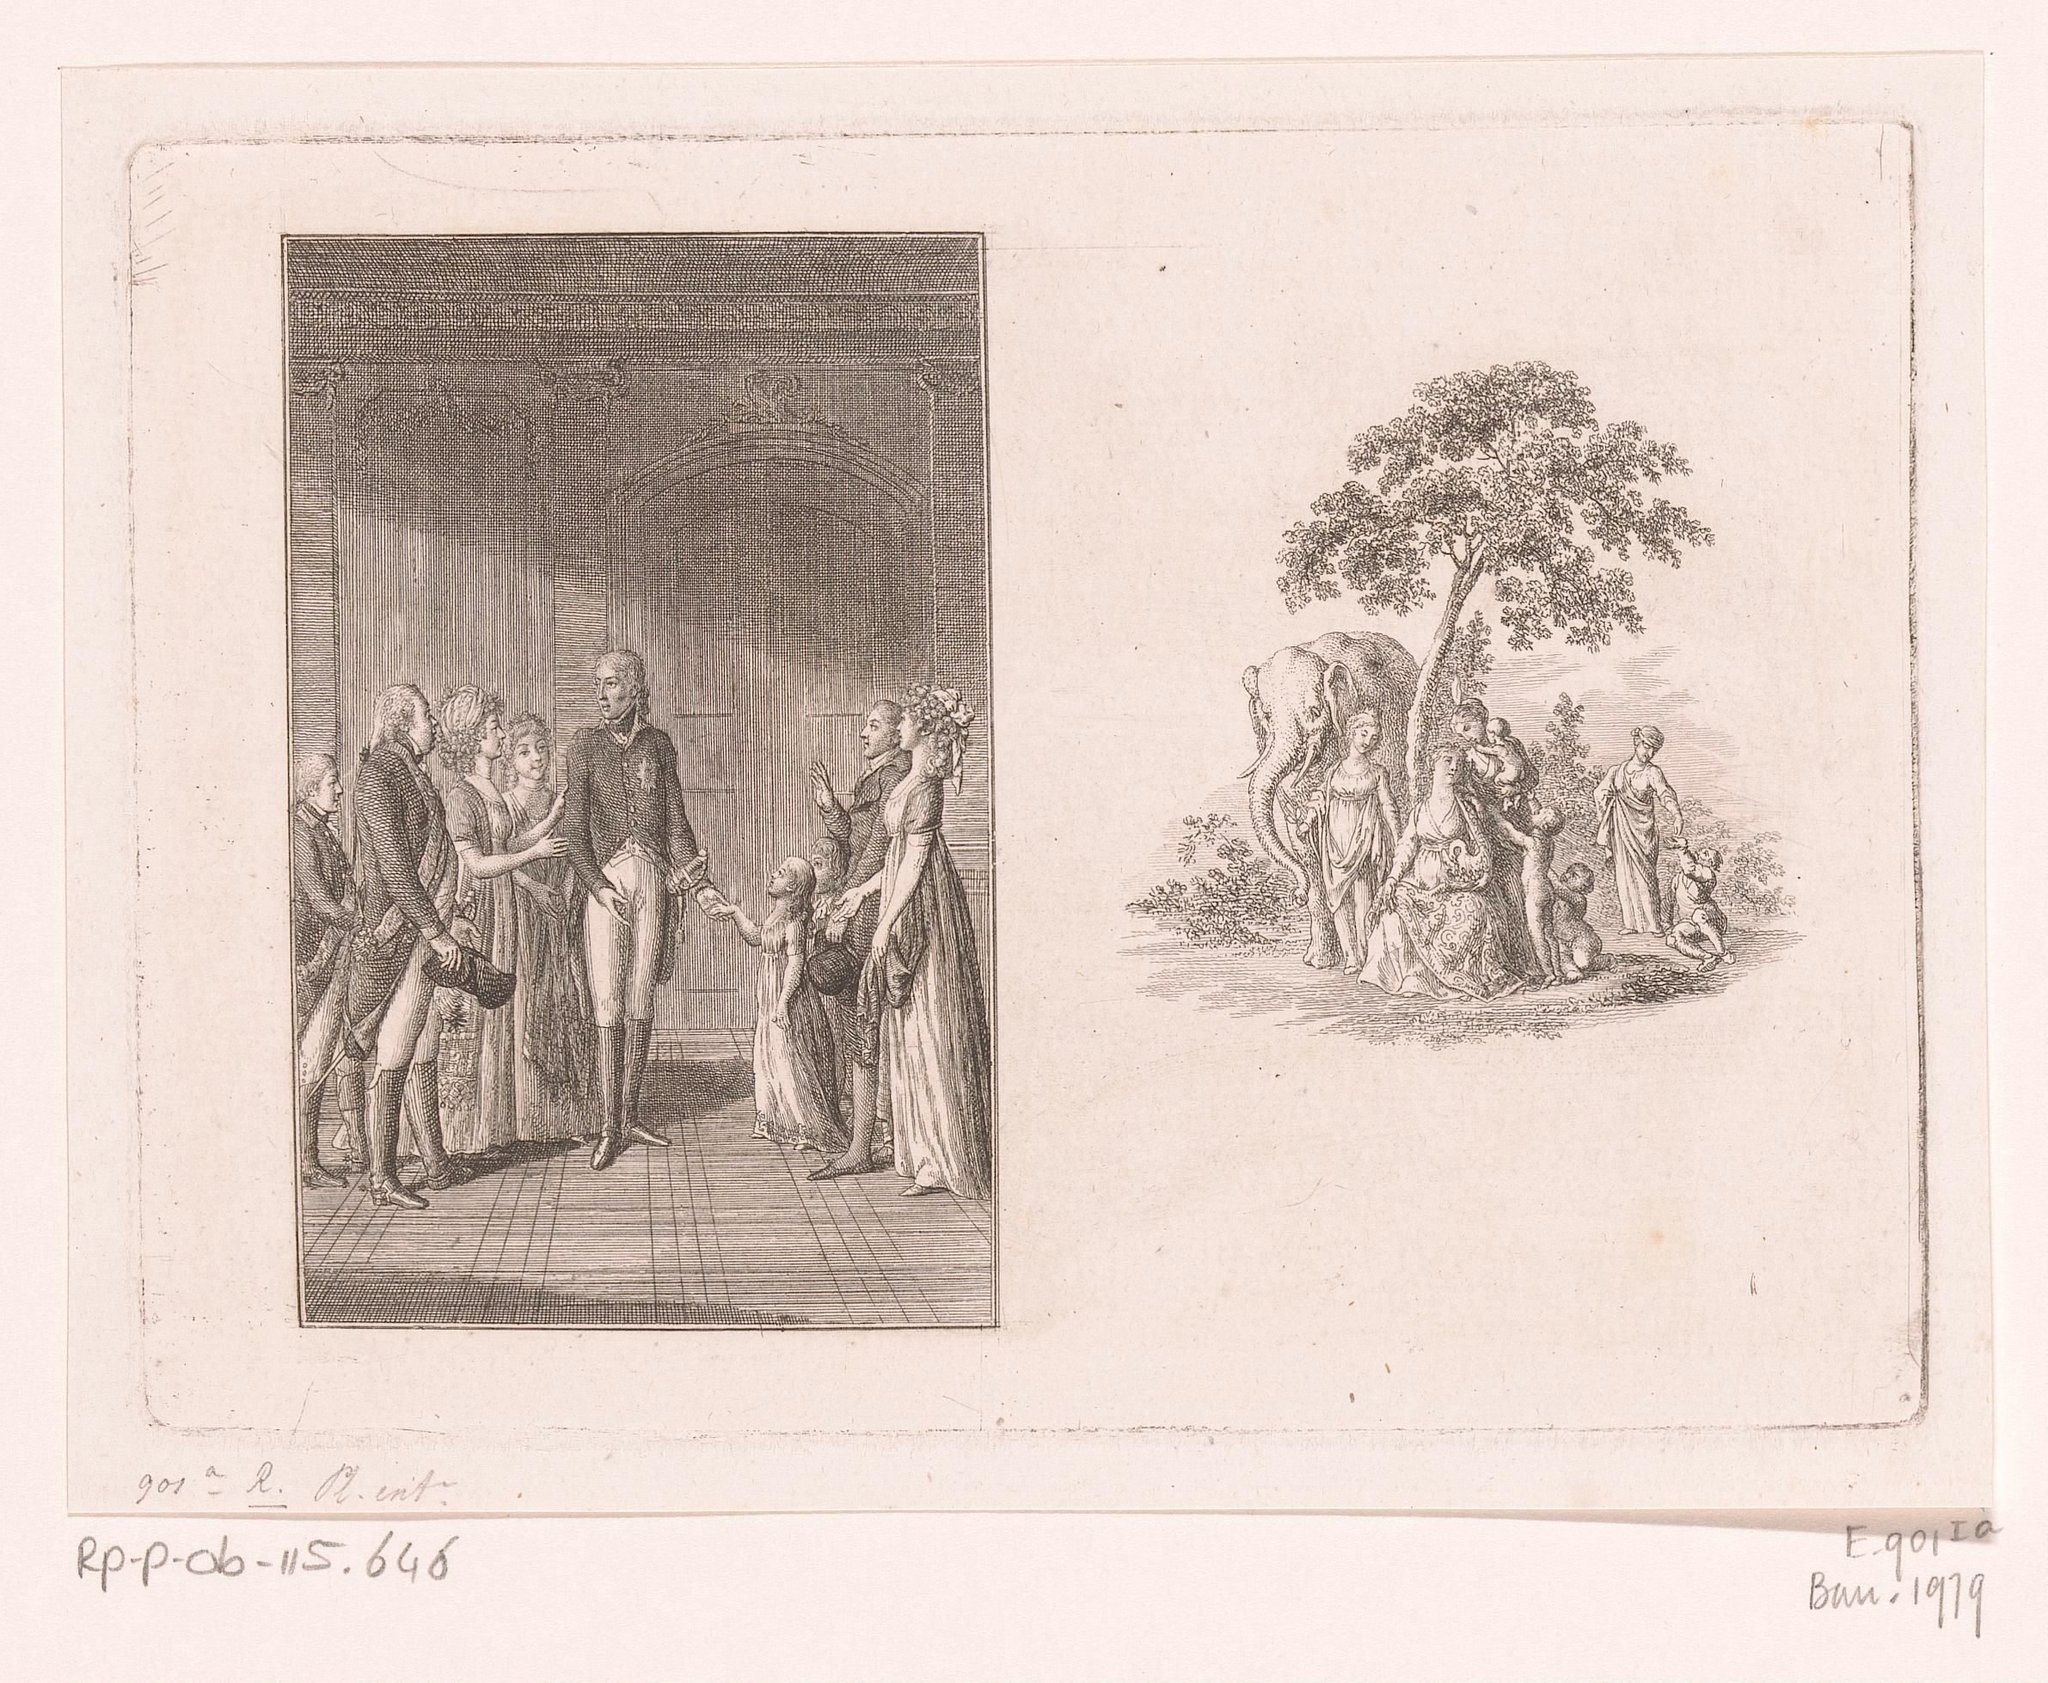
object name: print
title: Friedrich Wilhelm III met zijn gezin na de dood van zijn vader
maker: daniel nikolaus chodowiecki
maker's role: draughtsman, print maker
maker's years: 1726-1801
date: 1799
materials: paper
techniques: etching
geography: berlin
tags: berlin, frederik willem iii koning van pruisen, royal bastards, landscapes, family, descendance, trunked animals: elephant, water-birds: pelican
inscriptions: collector's mark: Lugt 2228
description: Prent gebruikt voor: Taschenbuch auf das Jahr 1800 der Liebe und Freundschaft gewidmet. Bremen: Friedrich Wilmans, [1800].